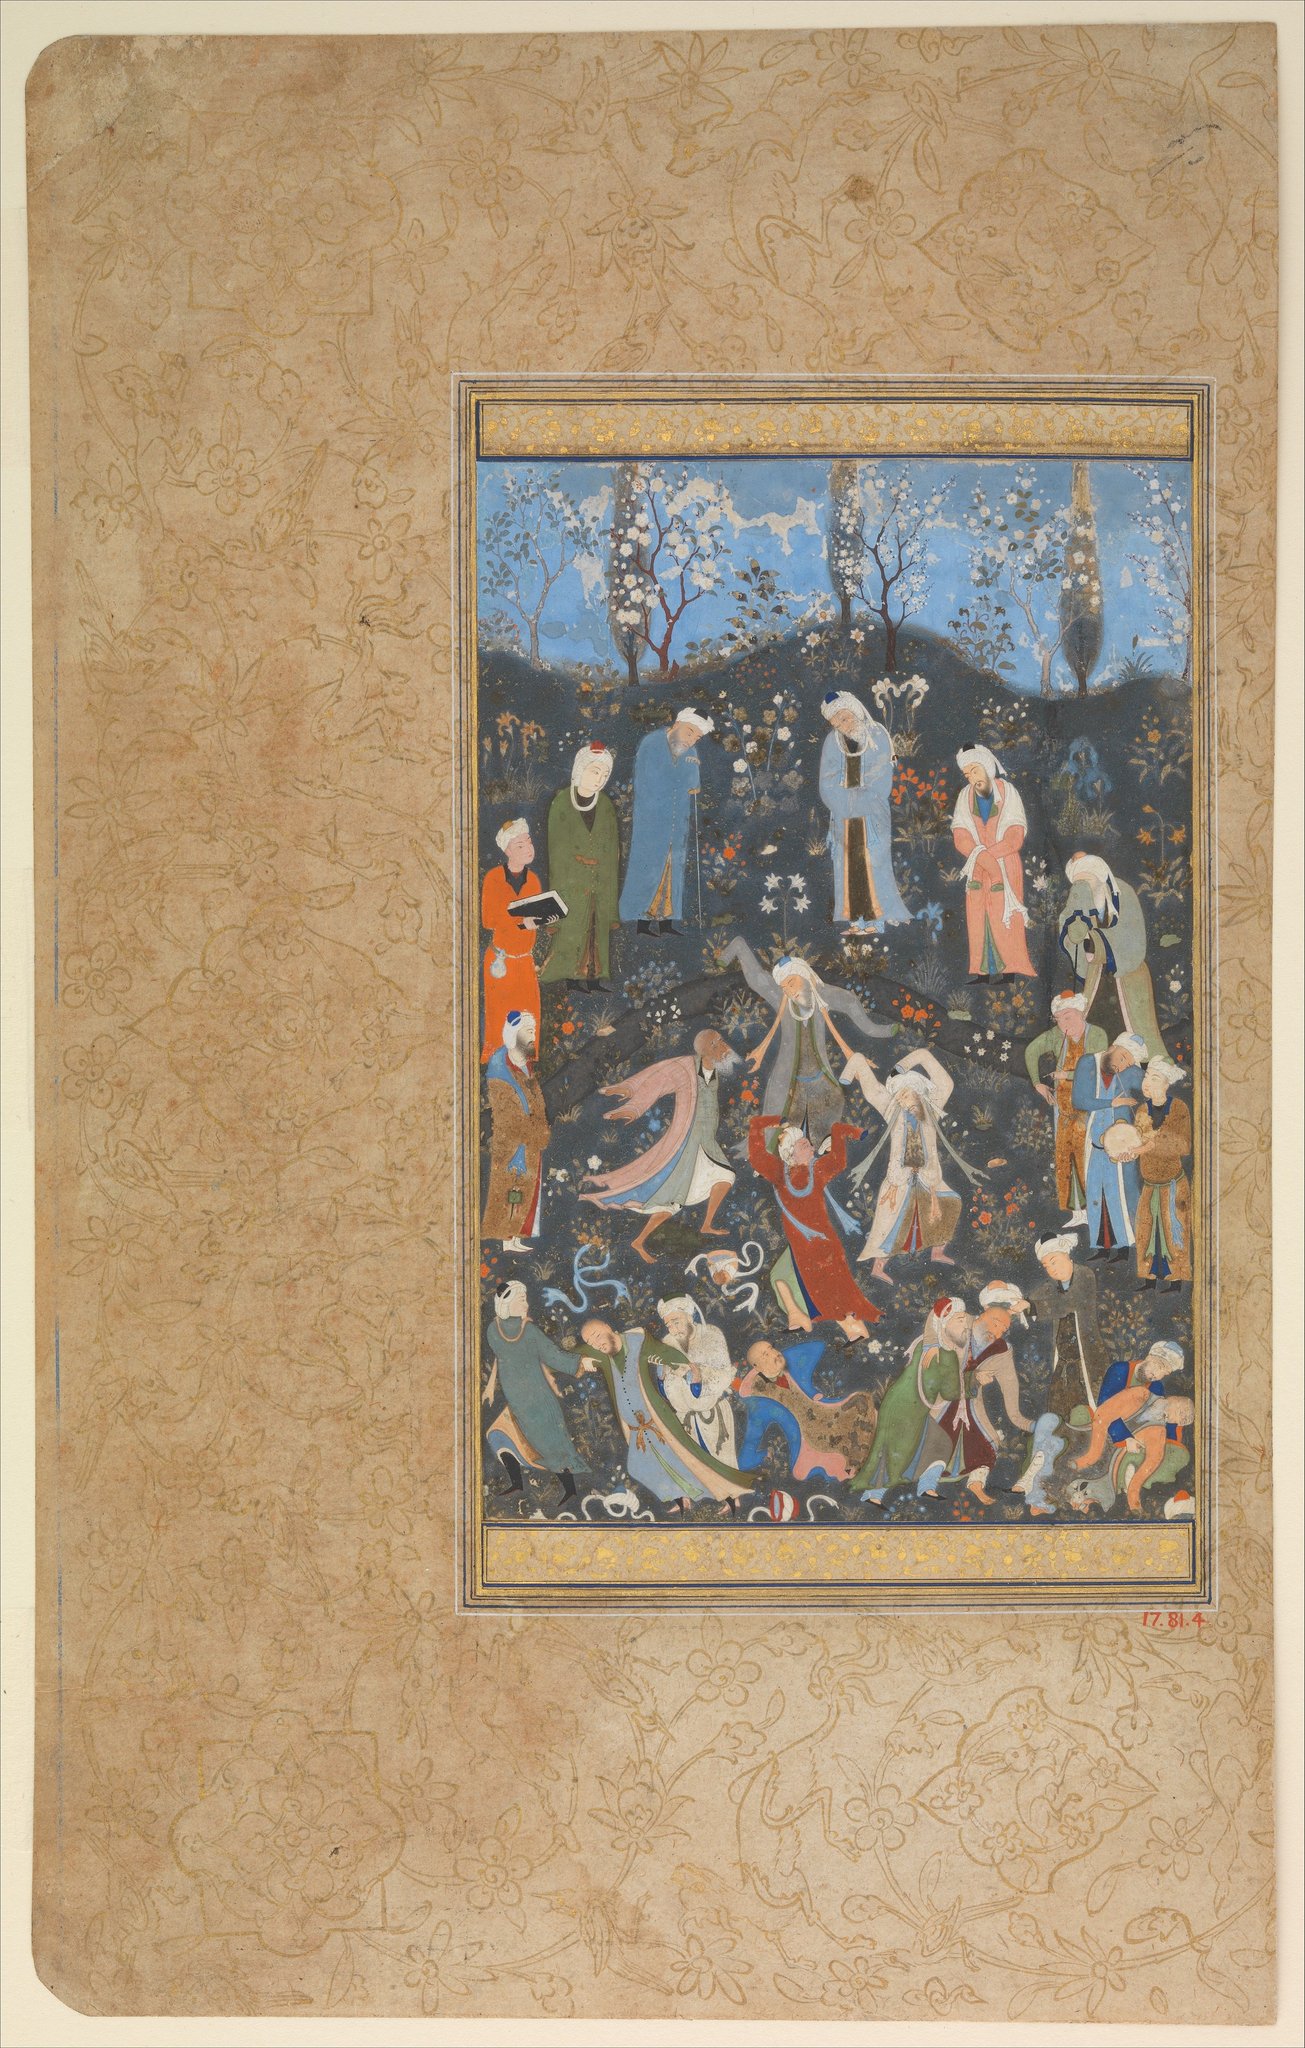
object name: folio from an illustrated manuscript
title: "Dancing Dervishes", Folio from a Divan of Hafiz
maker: hafiz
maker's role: poet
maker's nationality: iranian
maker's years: 1325-1390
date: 1480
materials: gold, paper, watercolor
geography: afghanistan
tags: men,dancing